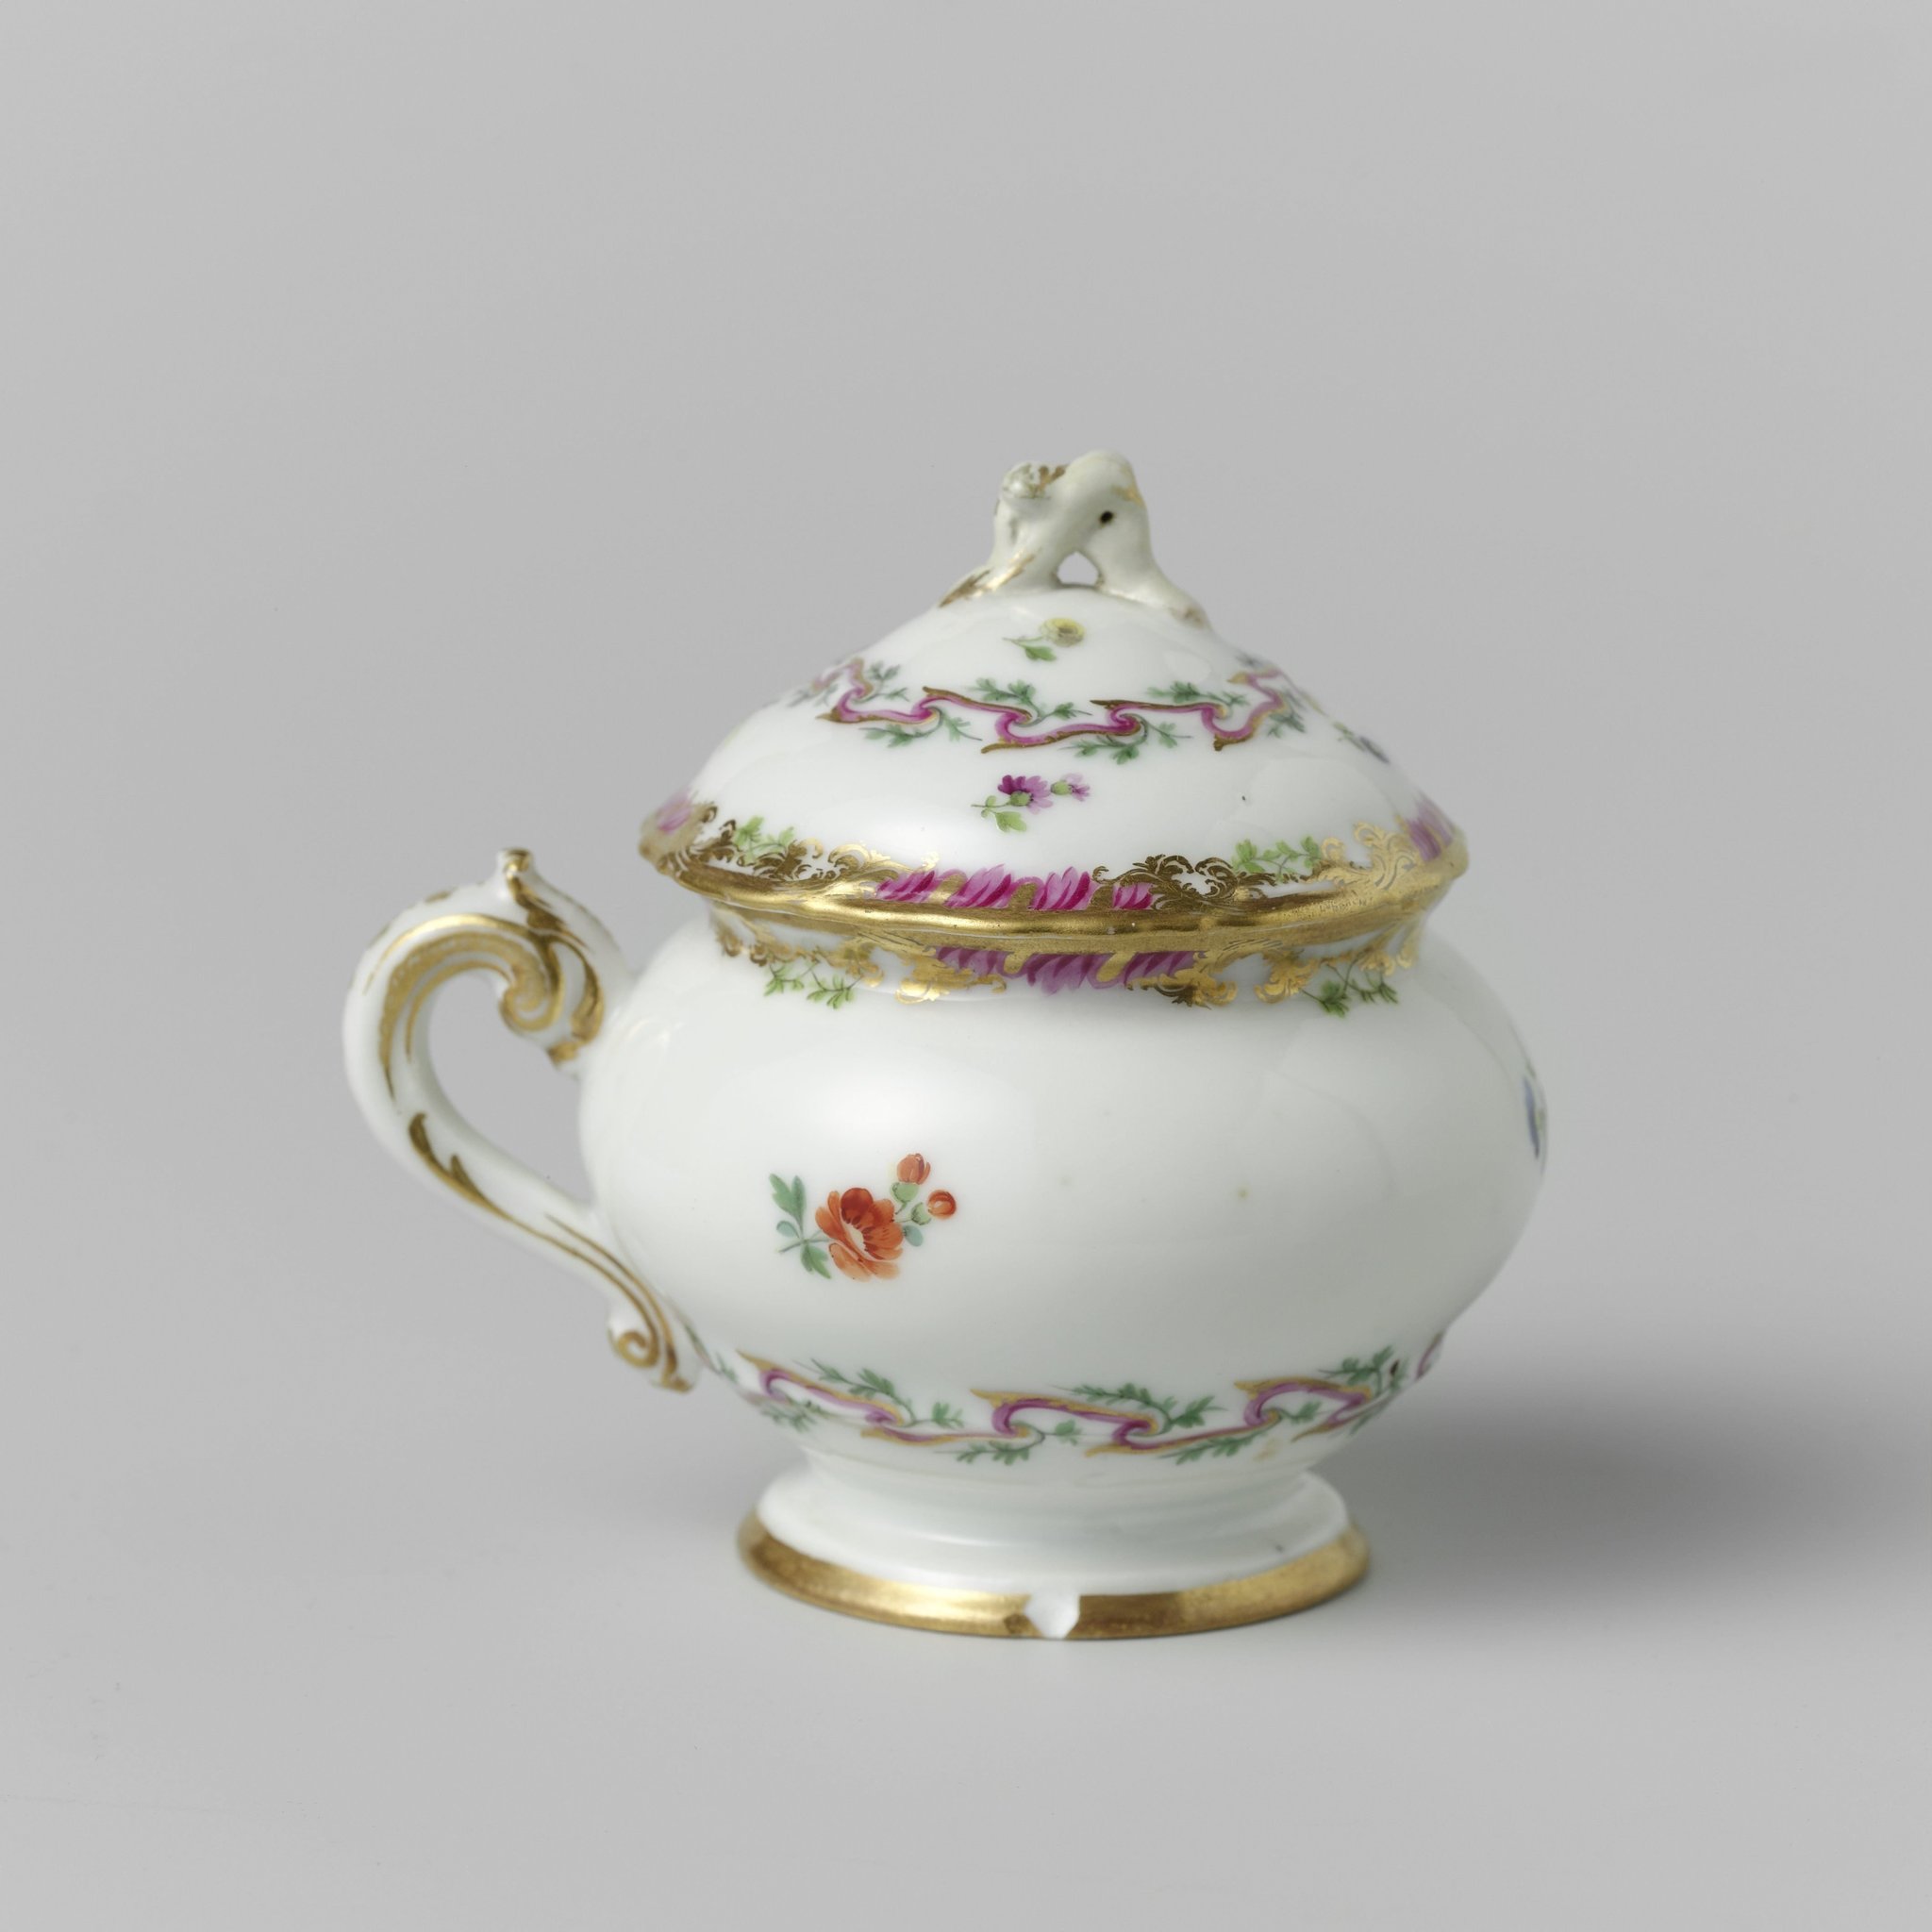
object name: pot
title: Pasteipot,rond,met deksel en oor, behorend bij een servies met geslingerd lintmotief met bladertakken, bloemboeketten en gestrooide bloemtakken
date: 1780-1820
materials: porcelain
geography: amsterdam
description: Pasteipot, rond, met deksel en oor, behorend bij een servies van porselein met geslingerd motief in paars en goud met groene bladertakken, bloemboeketten en gestrooide bloemtakken. Randen lichtgegolfd met decoratie in goud met paars bladmotief waartussen groen gekruist bladmotief. Gemerkt: M.O.L. en AMSTEL. Serie van elf stuks.